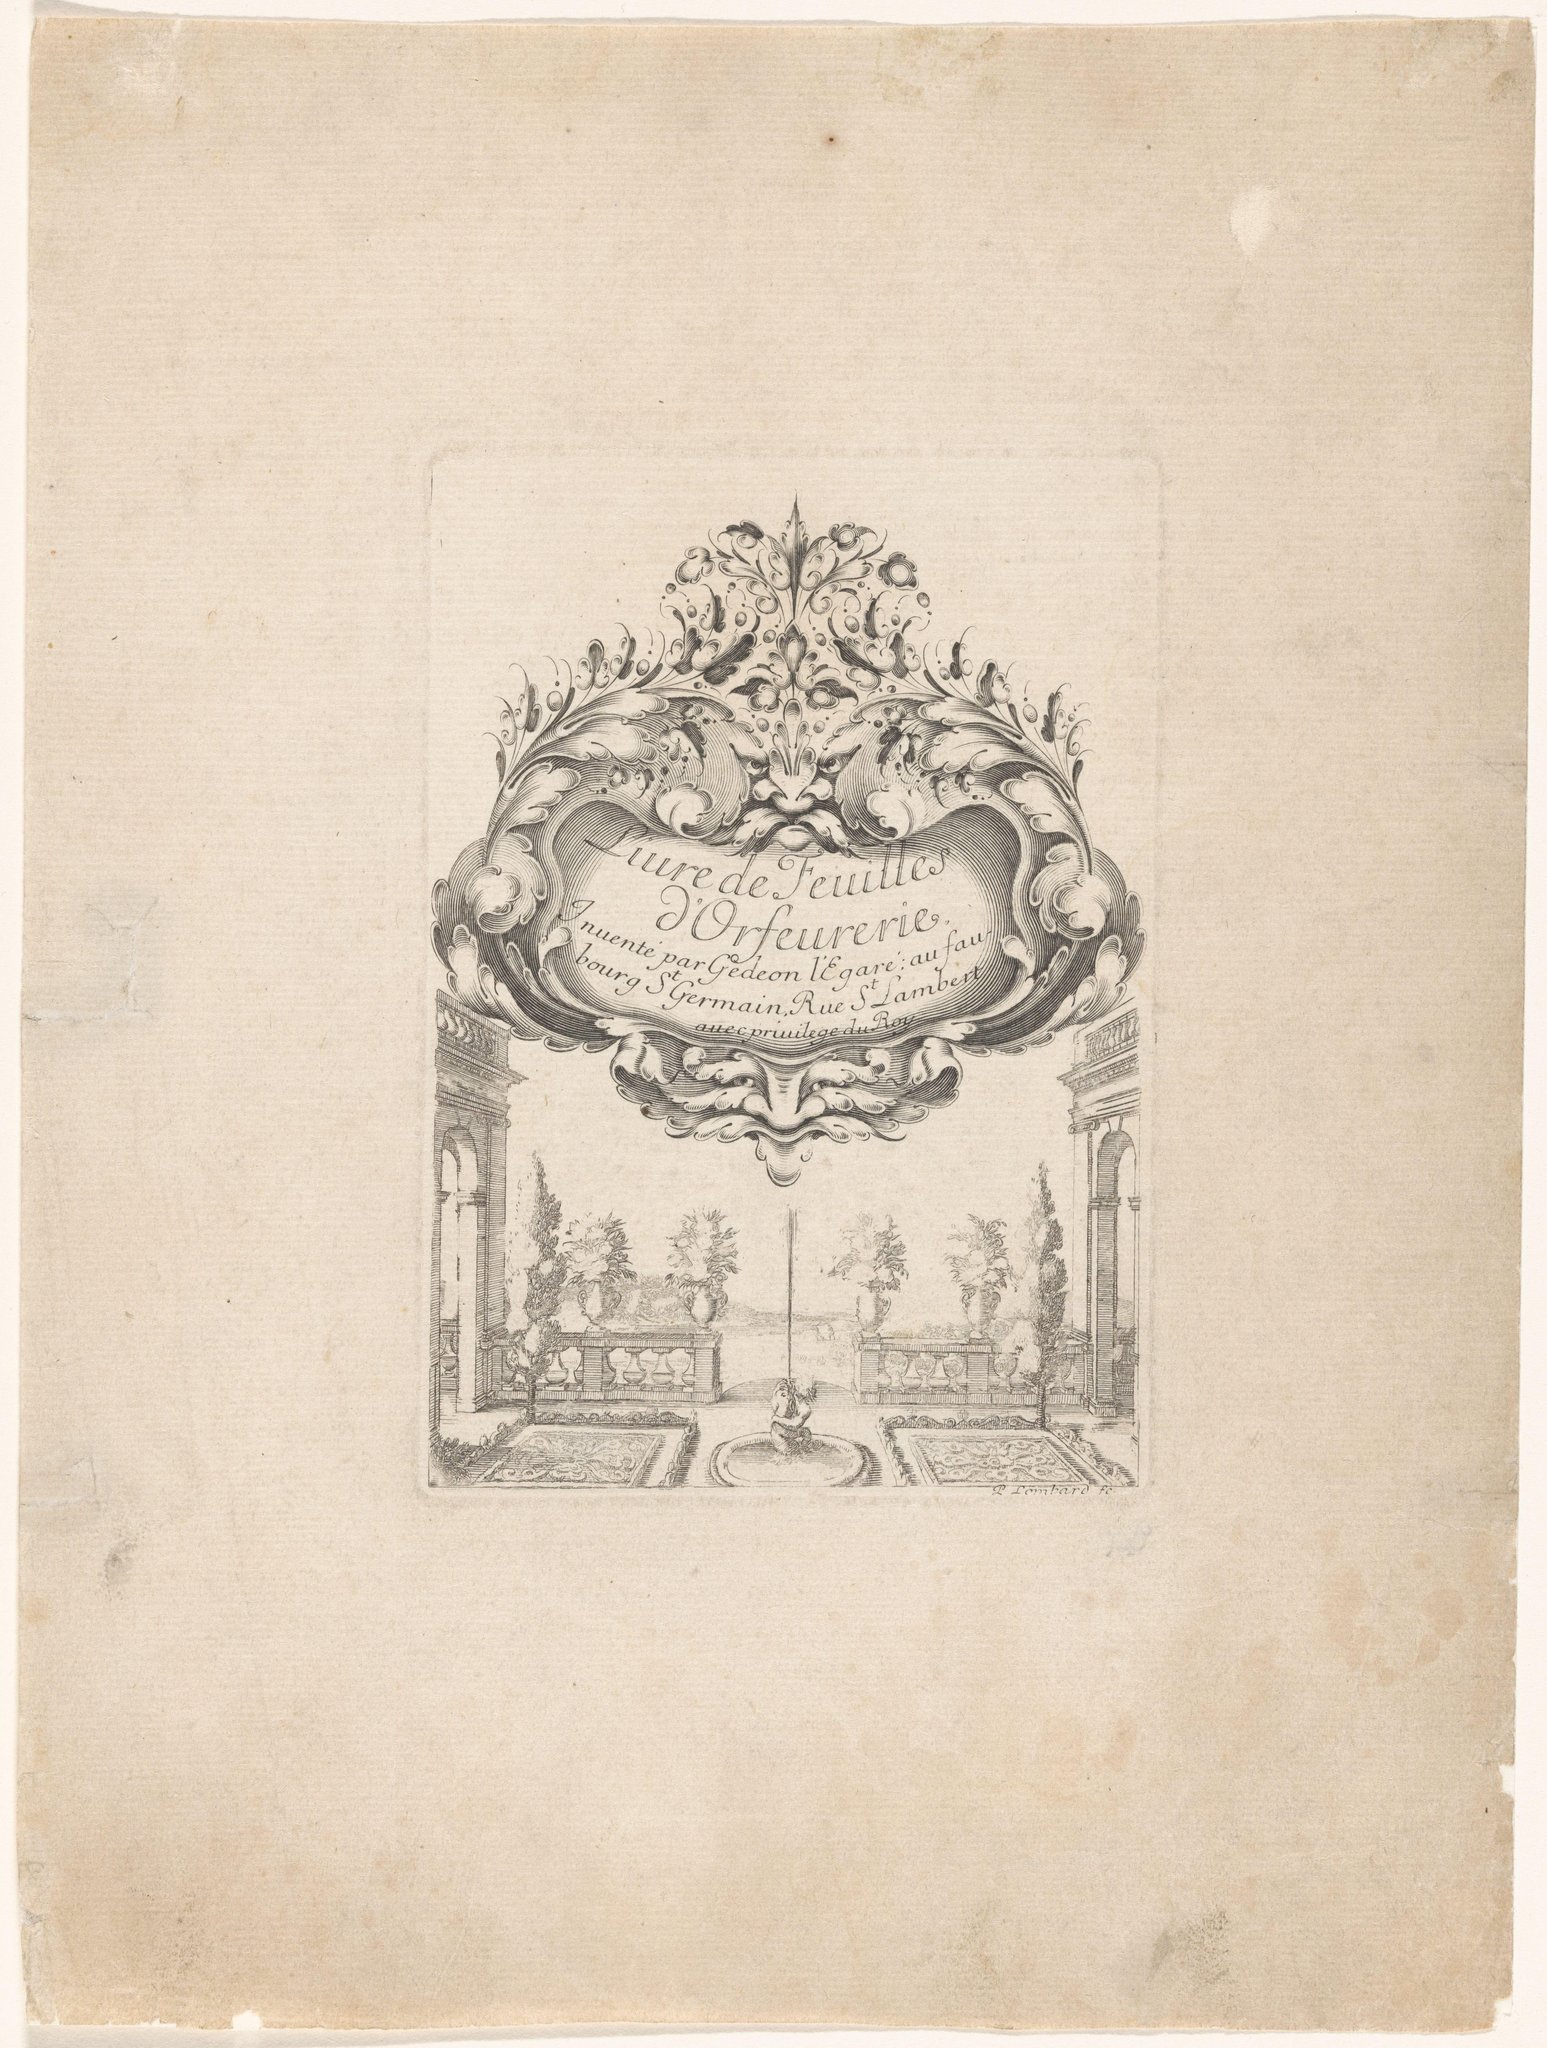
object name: print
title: Titelprent: Livre de Feuilles d'Orfevrerie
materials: paper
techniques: etching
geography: paris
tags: ornaments ~ art, colonnade, foliage ~ ornament, garden, garden fountain, title-page, ornament ~ cartouche, mask, mascaron ~ ornament, ornamental fountain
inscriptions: collector's mark: Lugt 895a, address: ‘au fau- / bourg St Germain, Rue St Lambert’, signature: ‘Inventé par Gedeon l'Egaré’, signature: ‘P. Lombard fe’, collector's mark: Lugt 2760, privilege: ‘avec privilege du Roy’, collector's mark: Lugt 2228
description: Titelprent in 'cosses de pois'-stijl van een serie van zeven bladen met edelsmidboeketten. Cartouche met twee maskers gekroond met bladeren. De cartouche rust links en rechts op een zuilengalerij en toont hieronder in perspectief een tuin met een fontein en een stadsgezicht achterin.